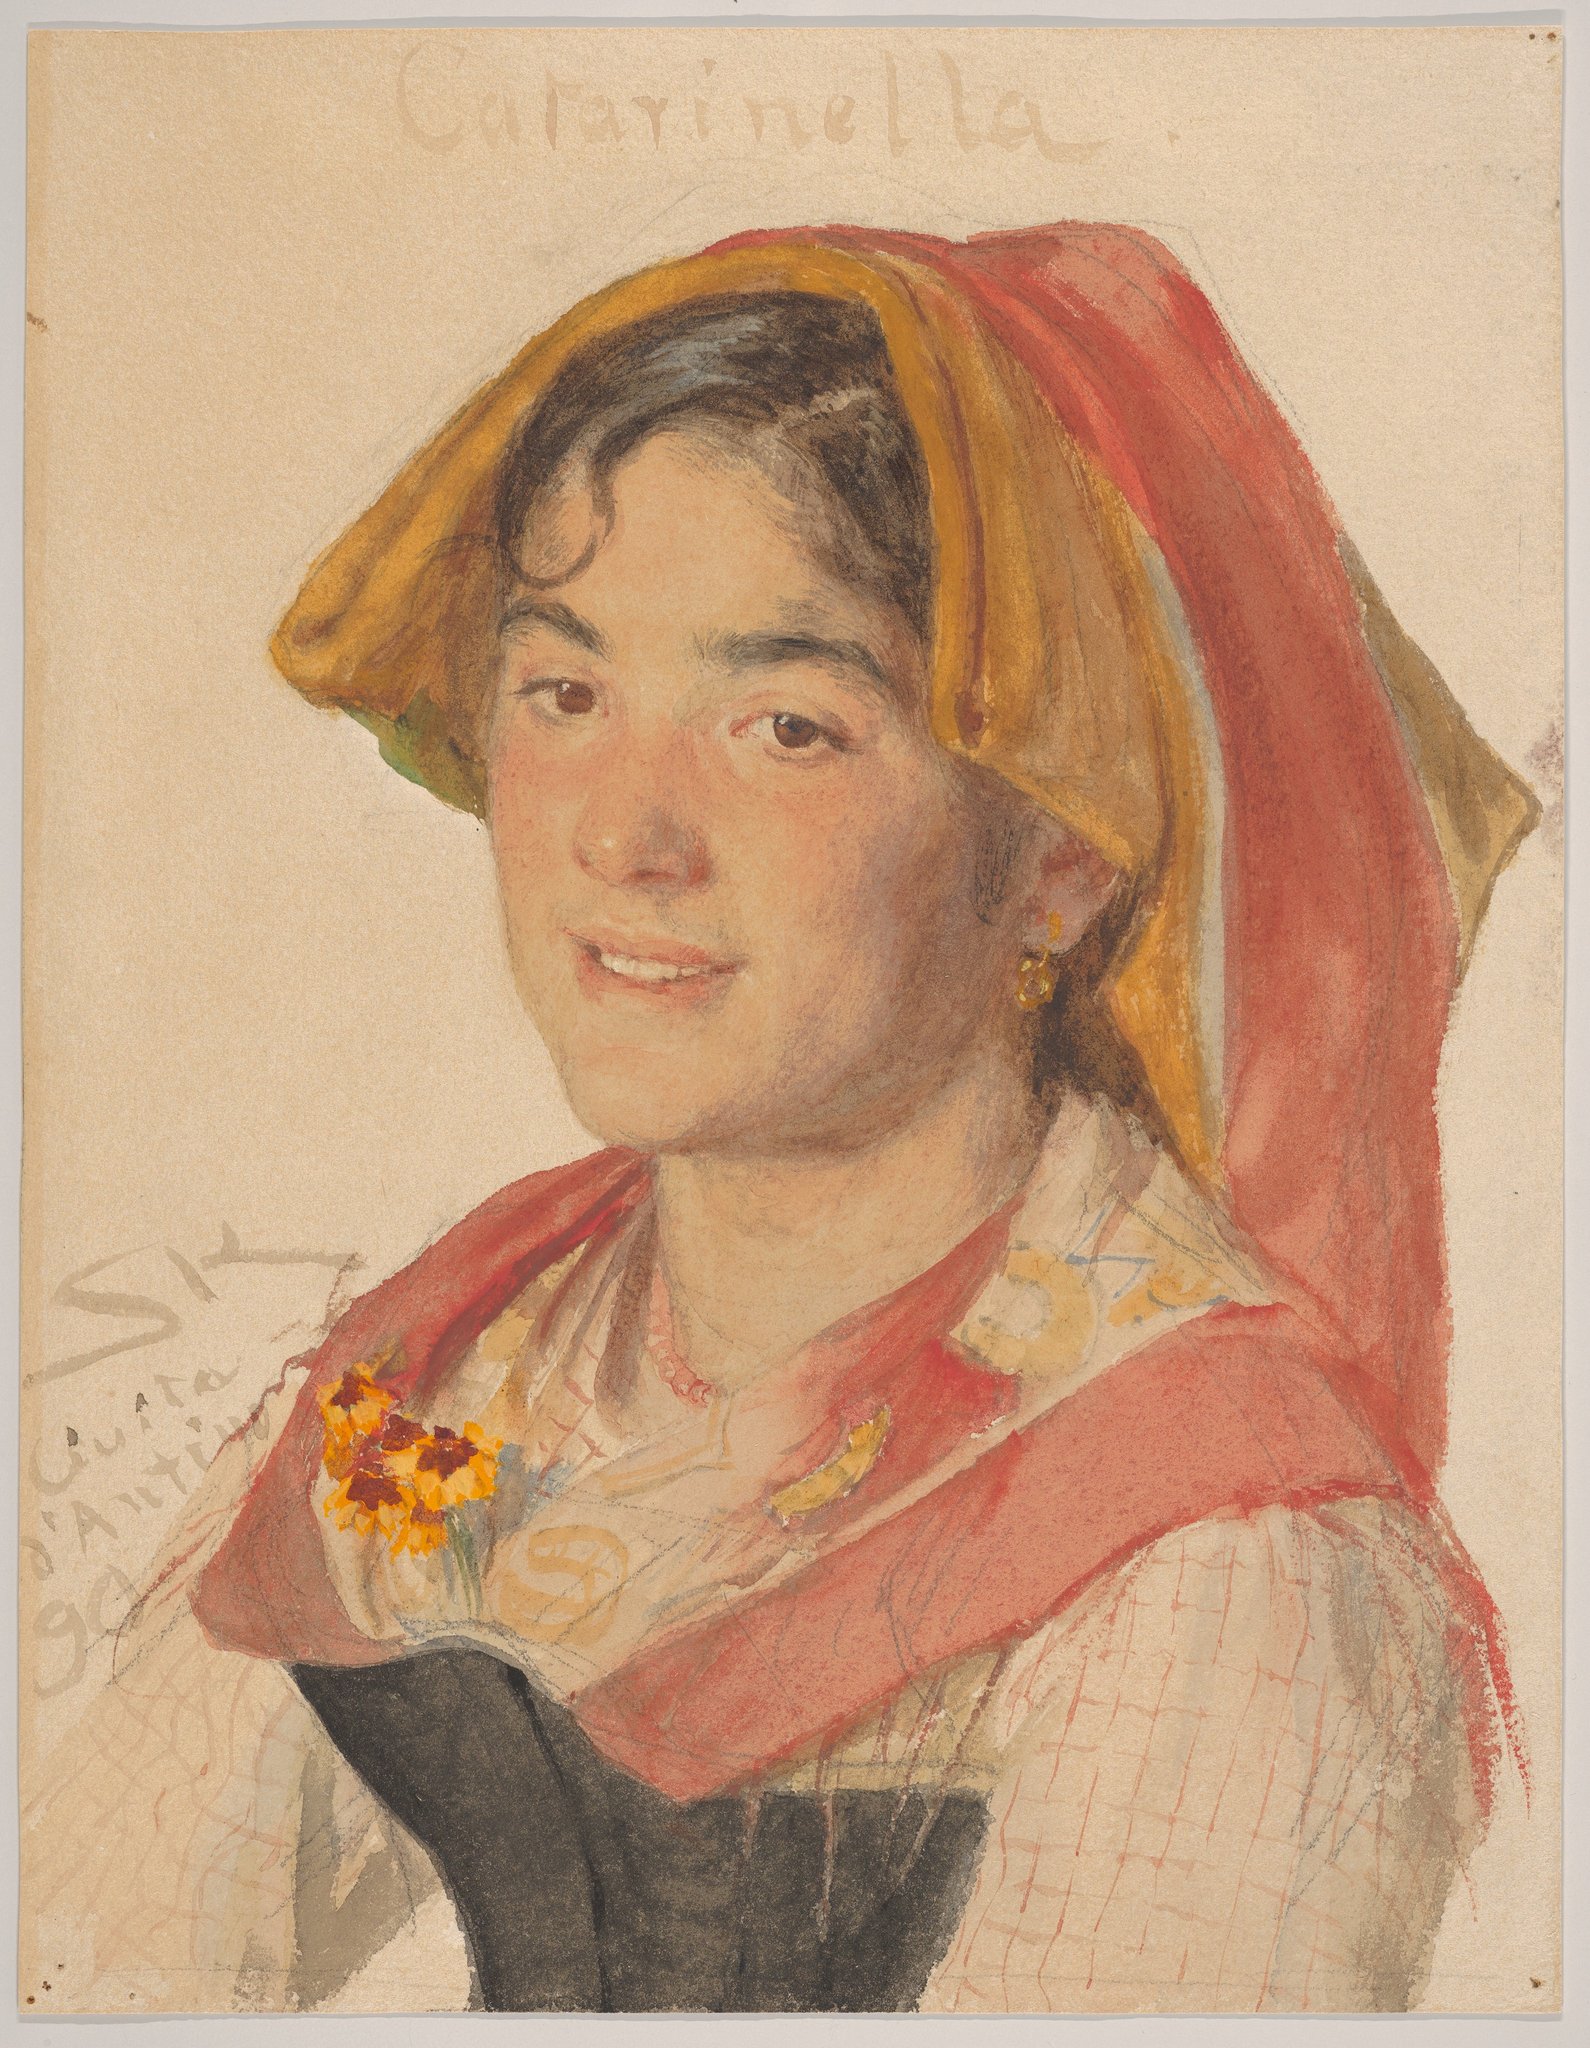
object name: drawing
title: Head of an Girl from Civita d'Antino in Regional Dress ("Catarinella")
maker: peder severin krøyer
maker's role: artist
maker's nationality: danish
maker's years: 1851-1909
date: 1890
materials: graphite, watercolor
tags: girls